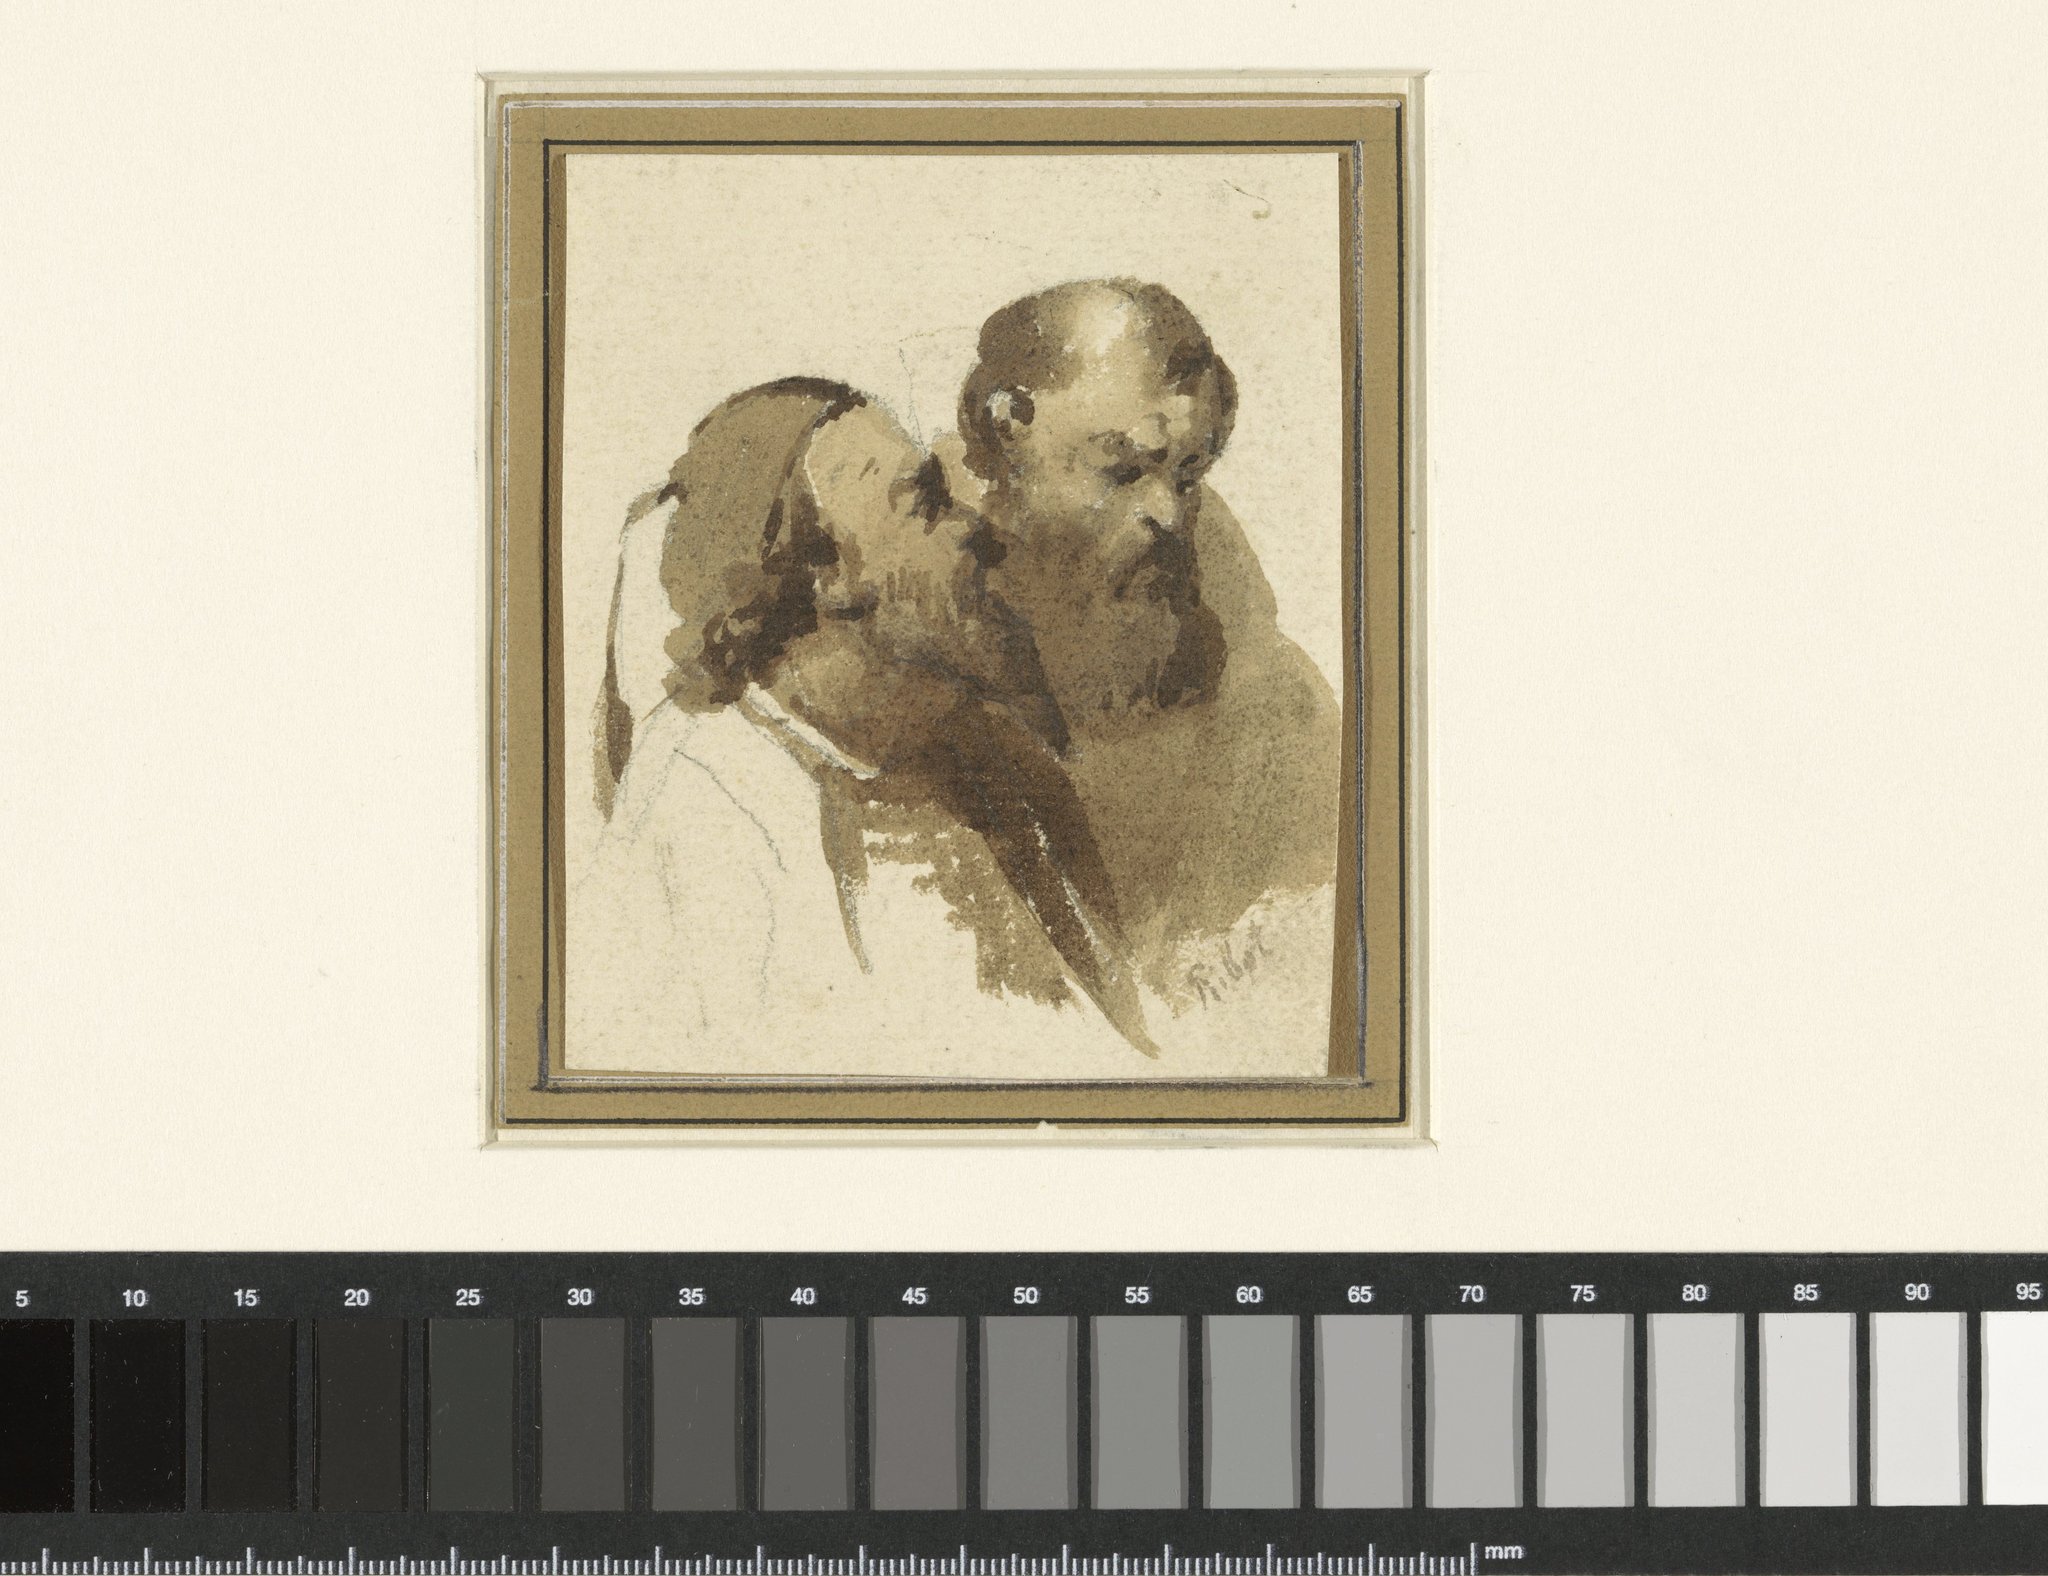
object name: drawing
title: Twee oosterse mannen, borstbeelden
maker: théodule augustin ribot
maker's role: draughtsman, painter, print maker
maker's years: 1823-1891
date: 1833-1891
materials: paper, pencil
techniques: brush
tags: asiatic races and peoples, old man